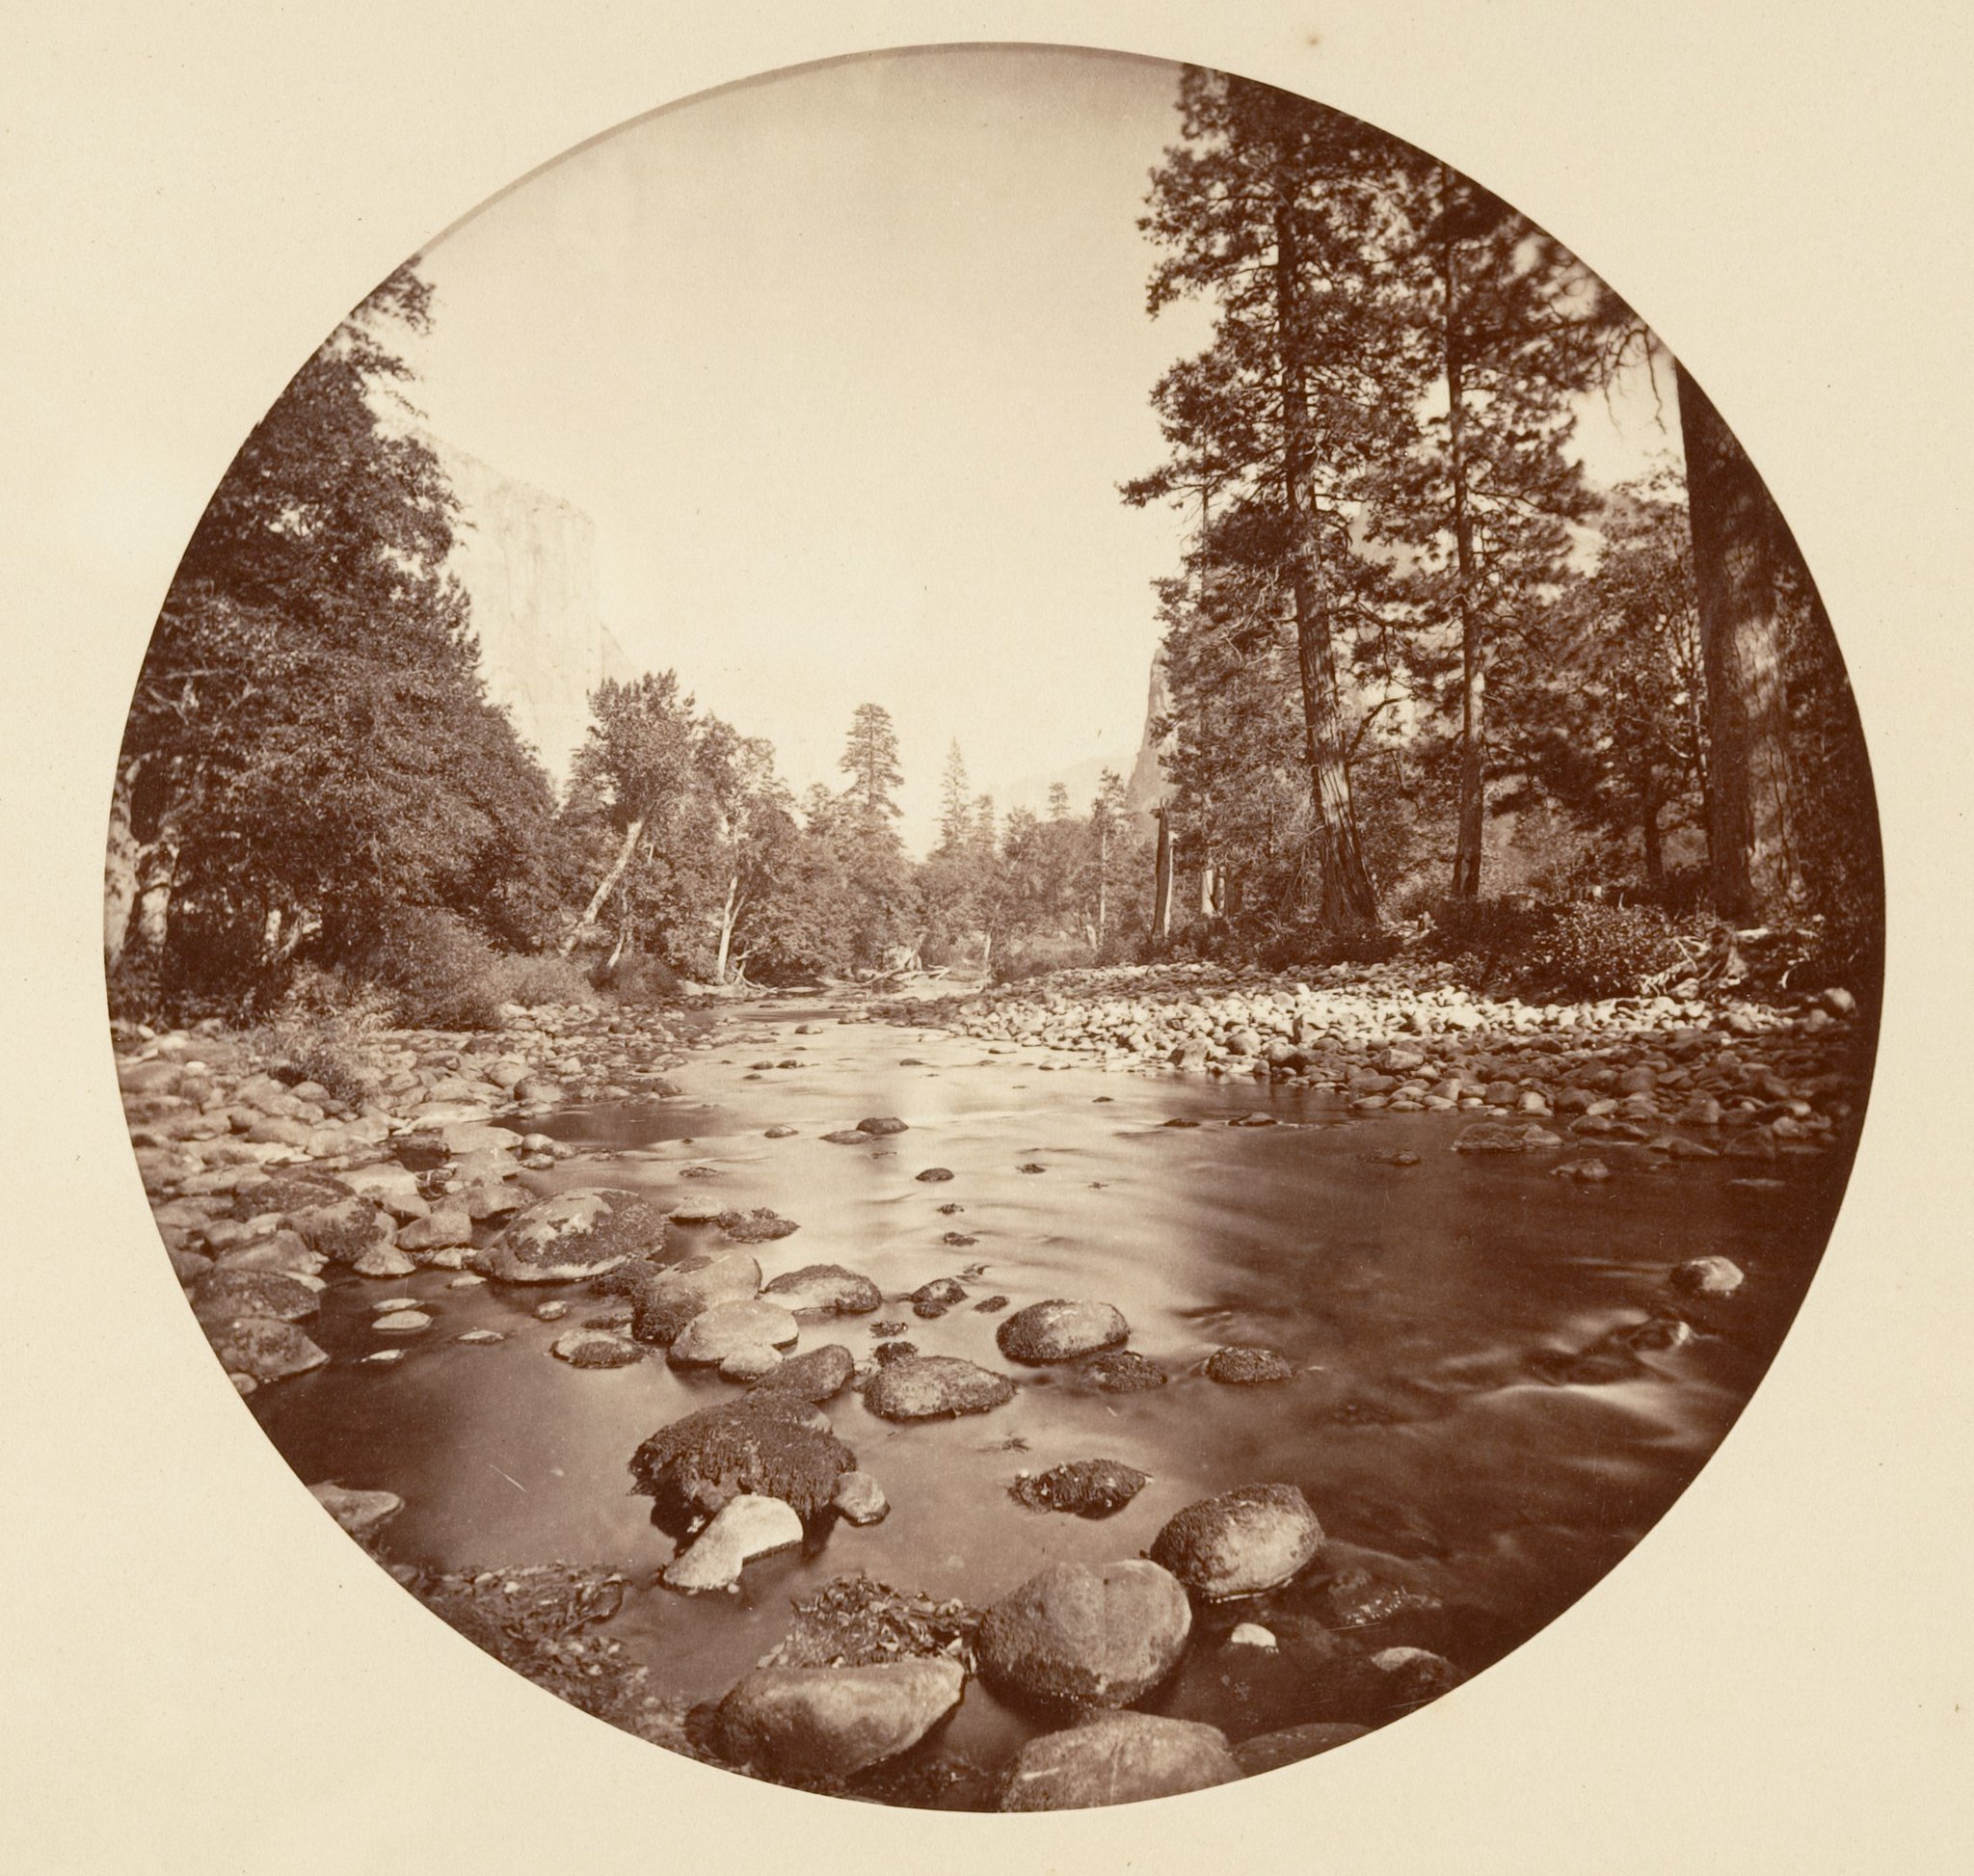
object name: photograph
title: [Yosemite National Park, California]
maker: carleton e. watkins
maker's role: artist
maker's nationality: american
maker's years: 1829-1916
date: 1878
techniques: albumen silver print, glass negative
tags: landscapes,streams